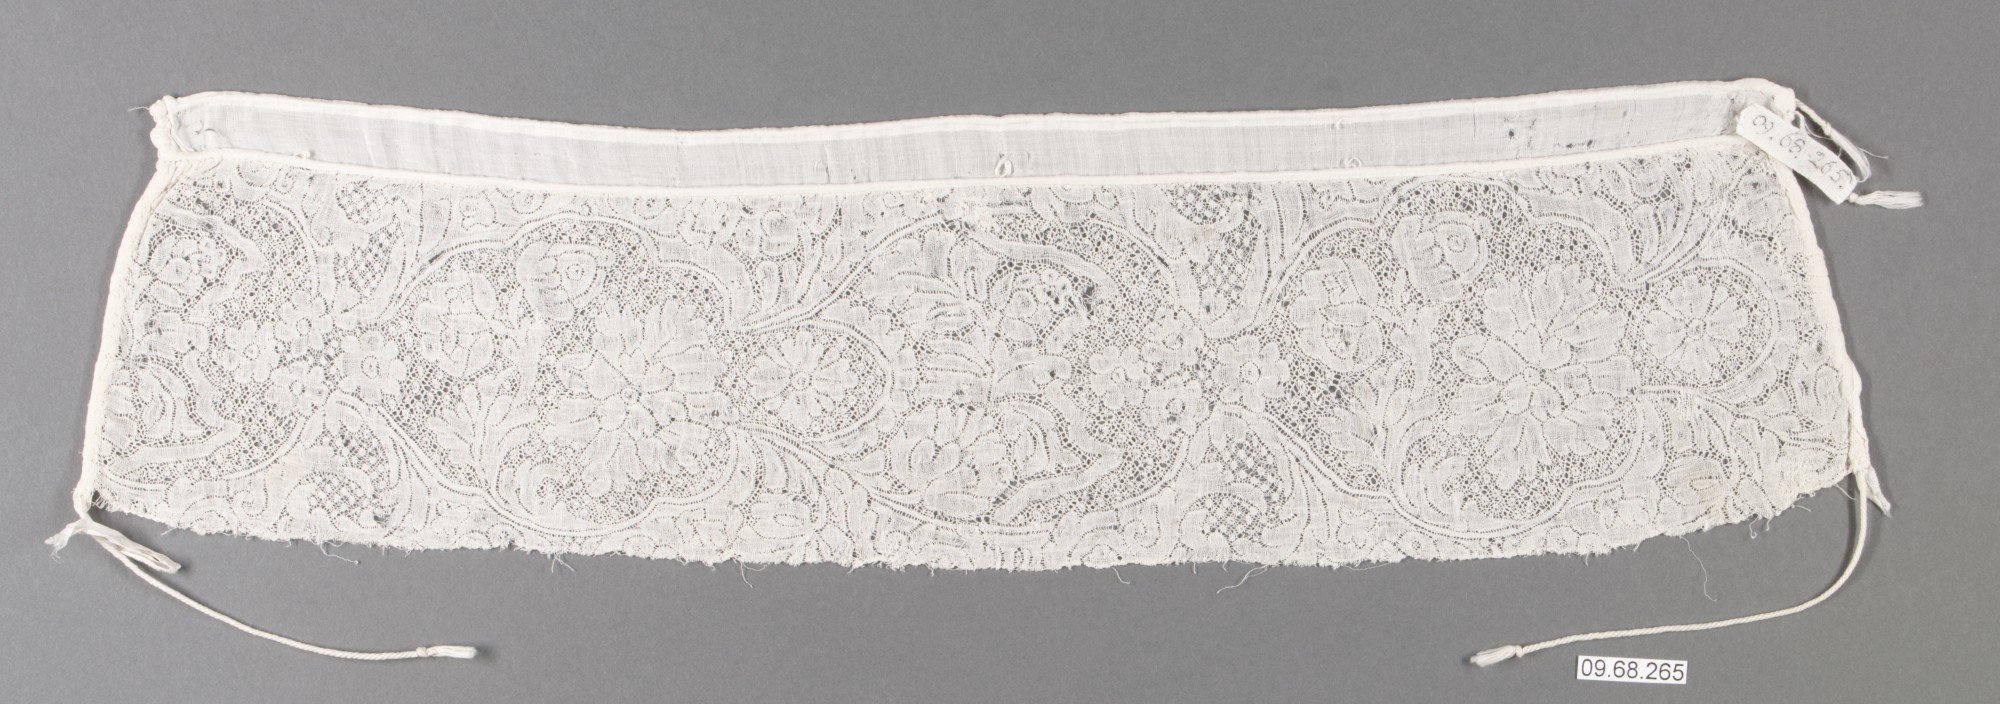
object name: cap band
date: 1601-1800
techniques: lace